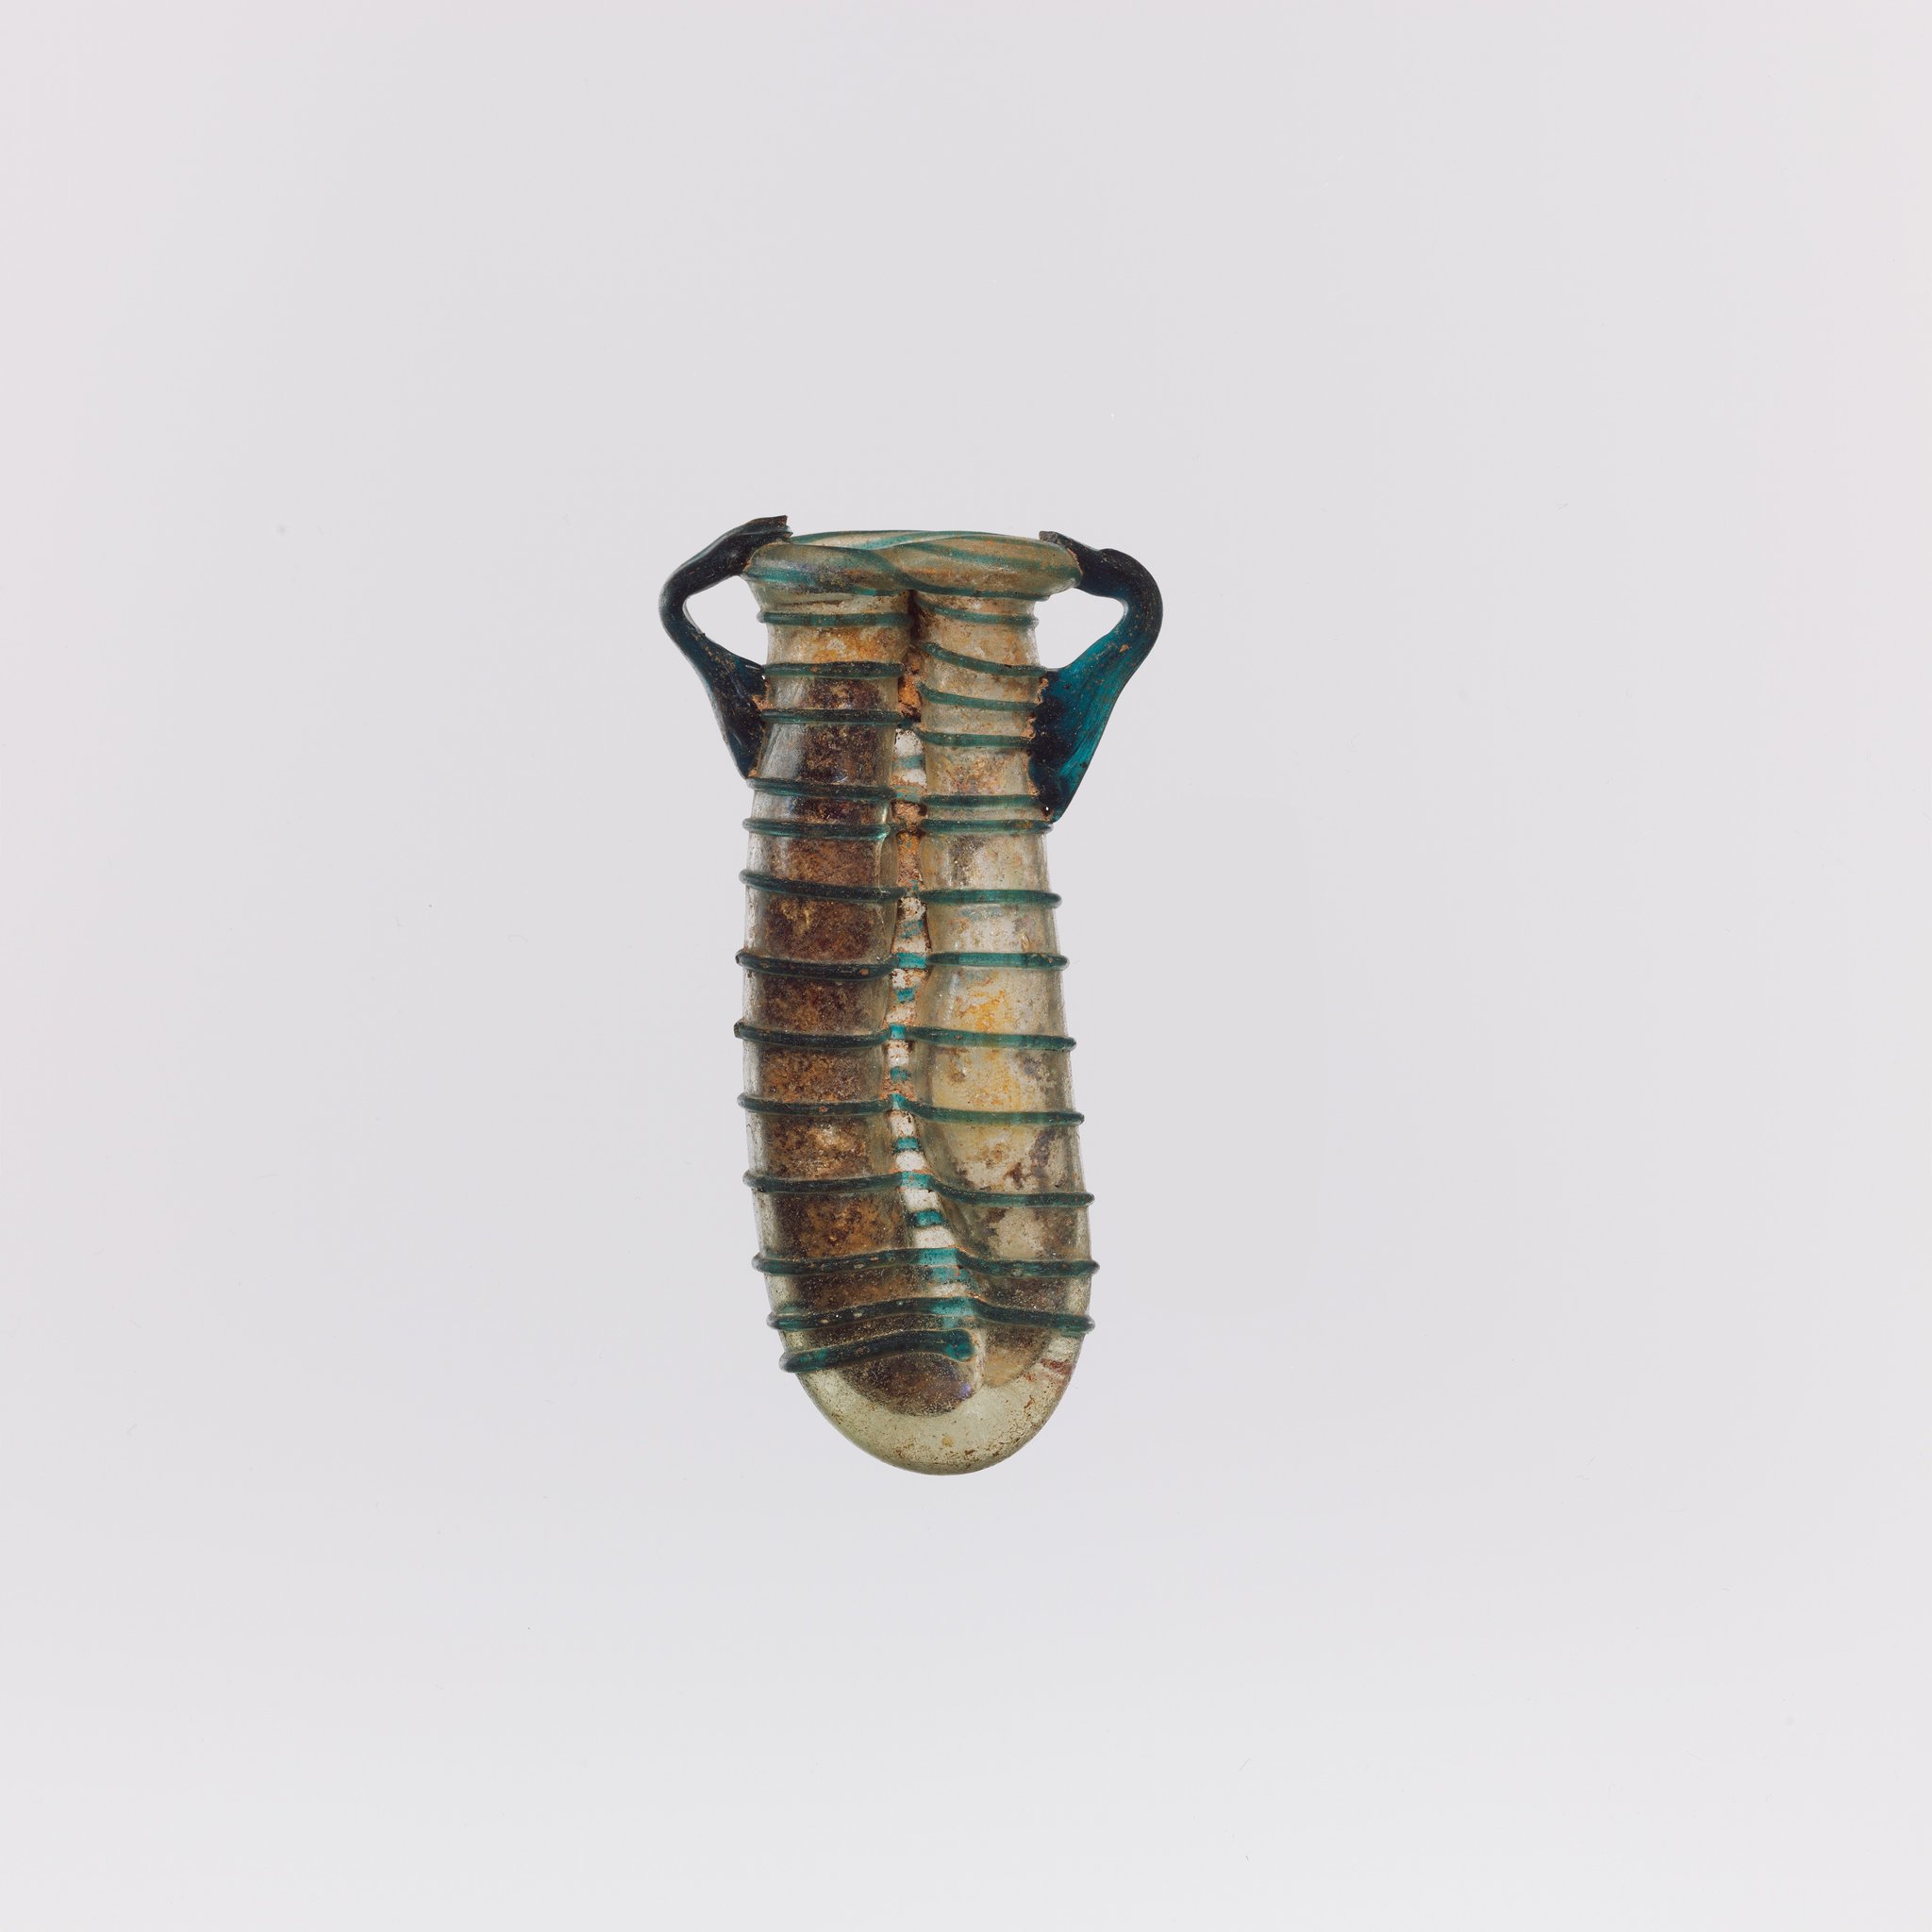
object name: cosmetic flask, double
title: Glass double cosmetic flask (kohl tube)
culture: roman, syrian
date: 301-400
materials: glass